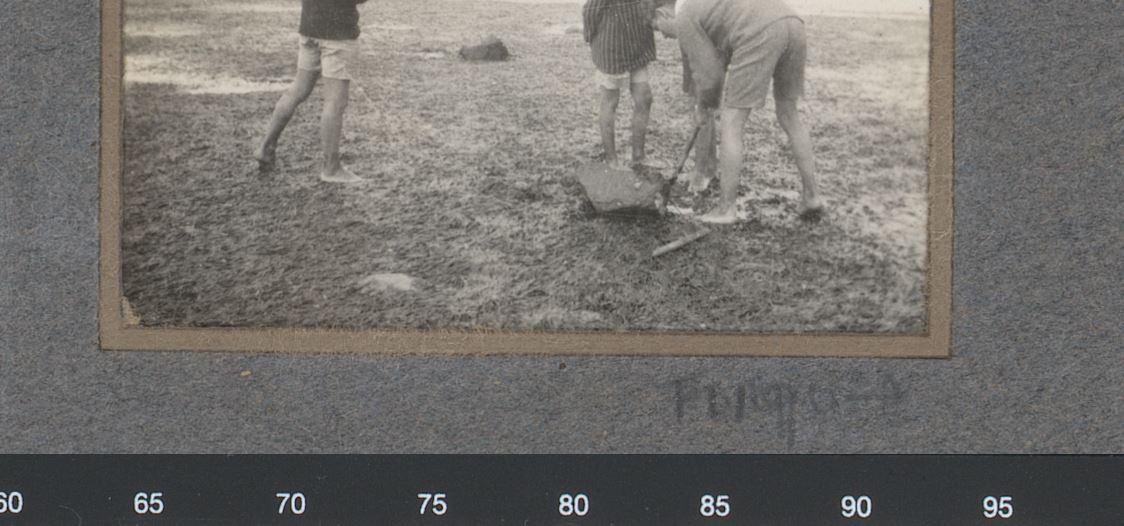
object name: photograph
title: Spelende jongens op het strand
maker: Anonymous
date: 1914-1935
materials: photographic support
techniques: gelatin silver print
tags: beach (as place of recreation), children's games and plays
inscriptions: inscription: ‘Opnamen gemaakt met de "Brownie" No.0./ Afdrukken gemaakt op "Velox" papier.’